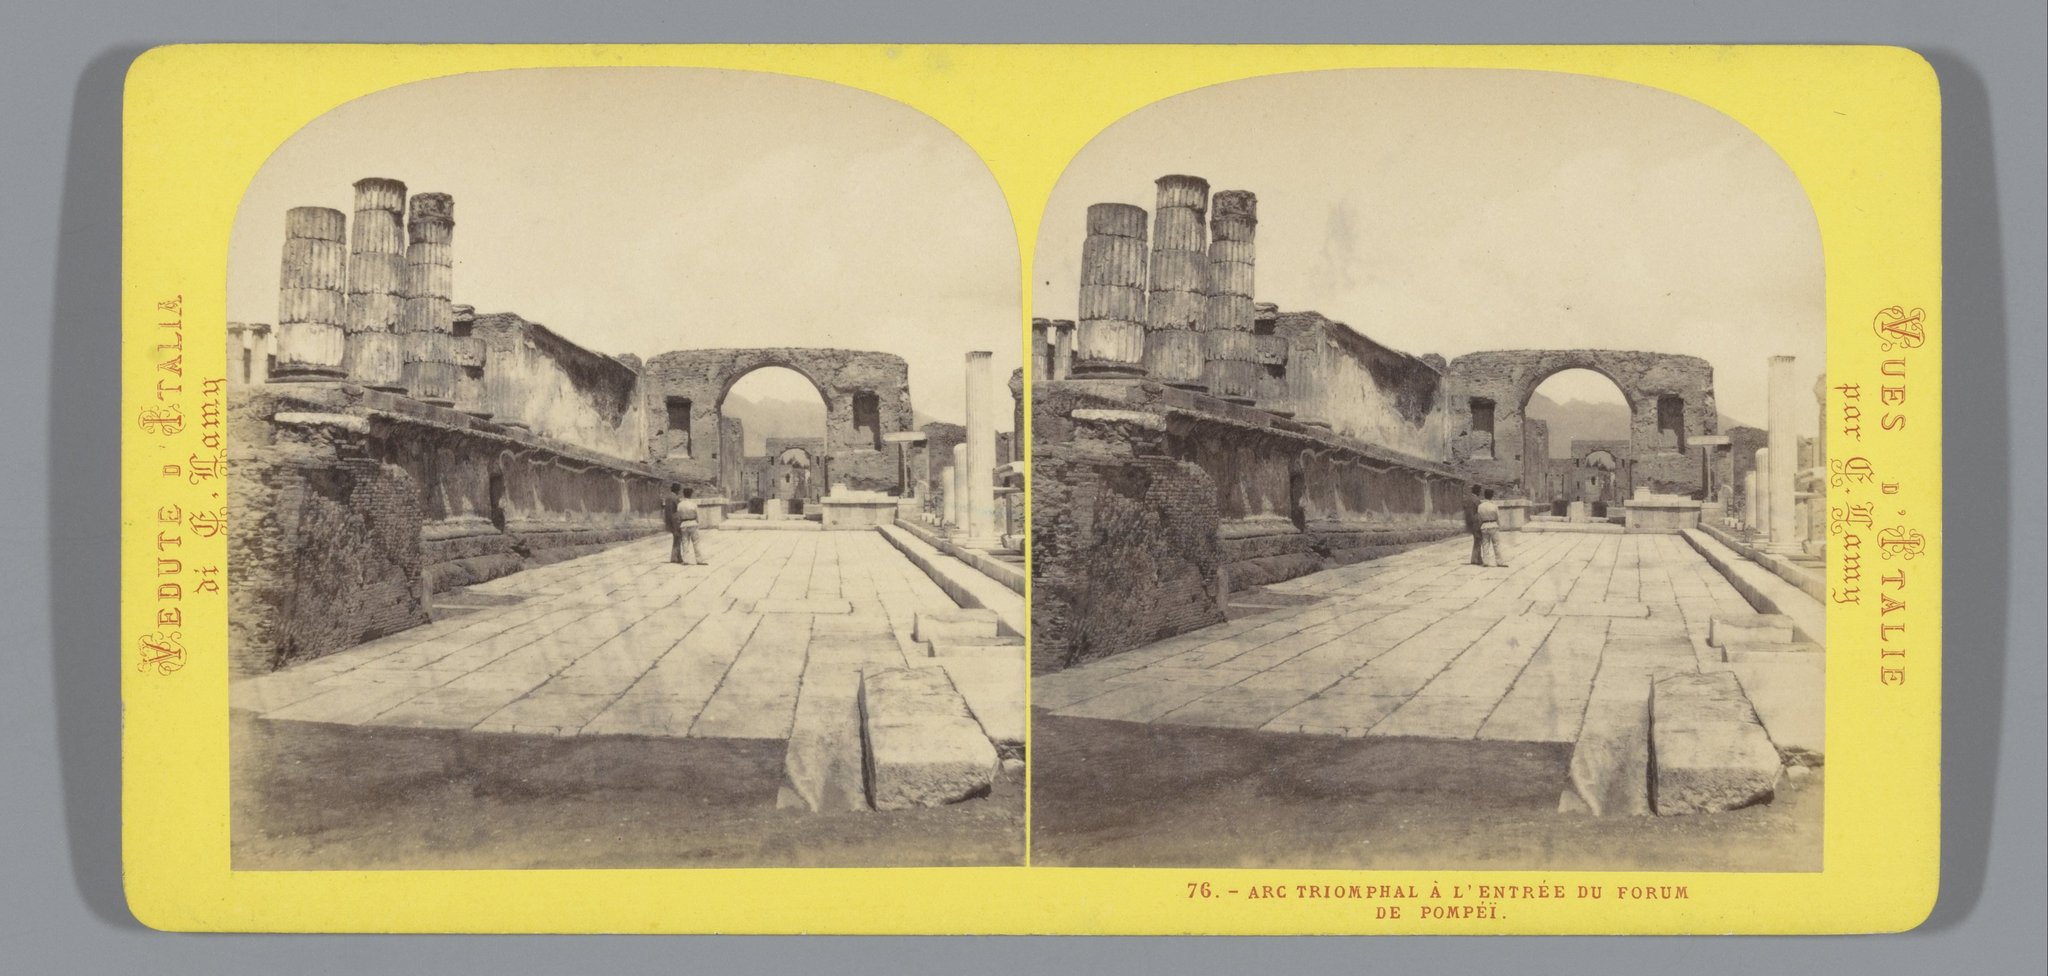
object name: stereograph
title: Boog van Tiberius op het Forum van Pompeï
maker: ernest eléonor pierre lamy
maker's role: publisher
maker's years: 1828-1900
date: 1861-1878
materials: cardboard, paper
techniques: albumen print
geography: pompeii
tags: triumphal arch, excavation ~ archaeology, pompeii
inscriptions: number: ‘76.’